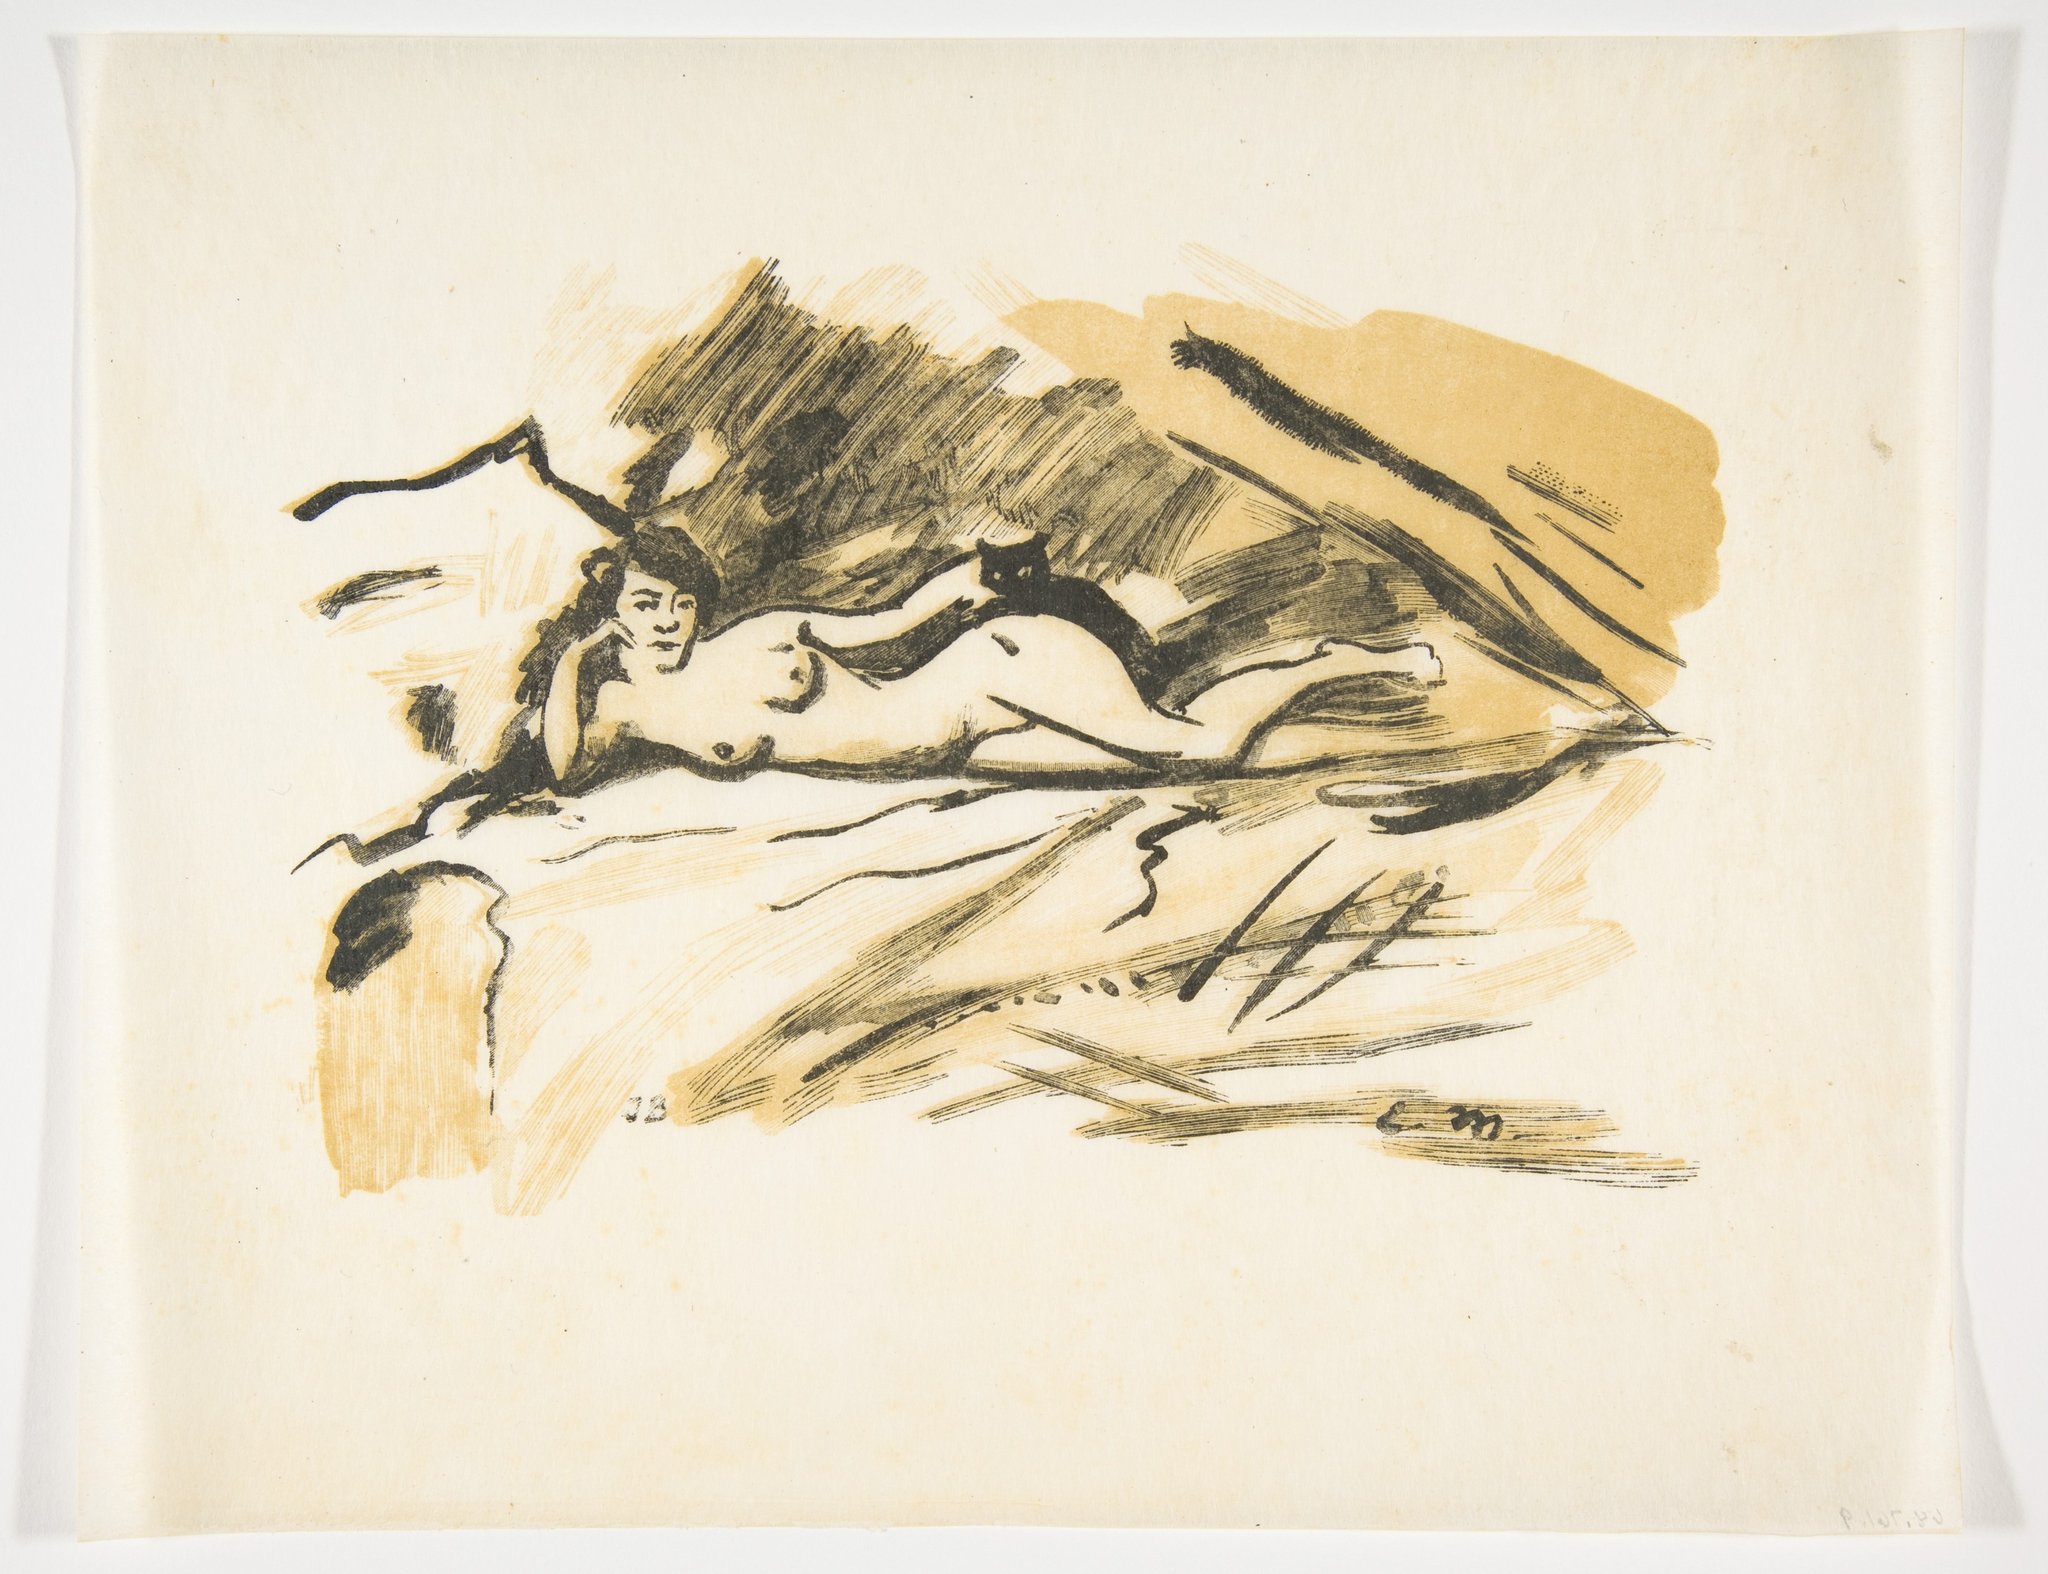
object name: print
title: Olympia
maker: édouard manet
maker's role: artist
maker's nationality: french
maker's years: 1832-1883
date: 1923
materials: ink, paper, parchment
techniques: woodcut, printing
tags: female nudes,cats